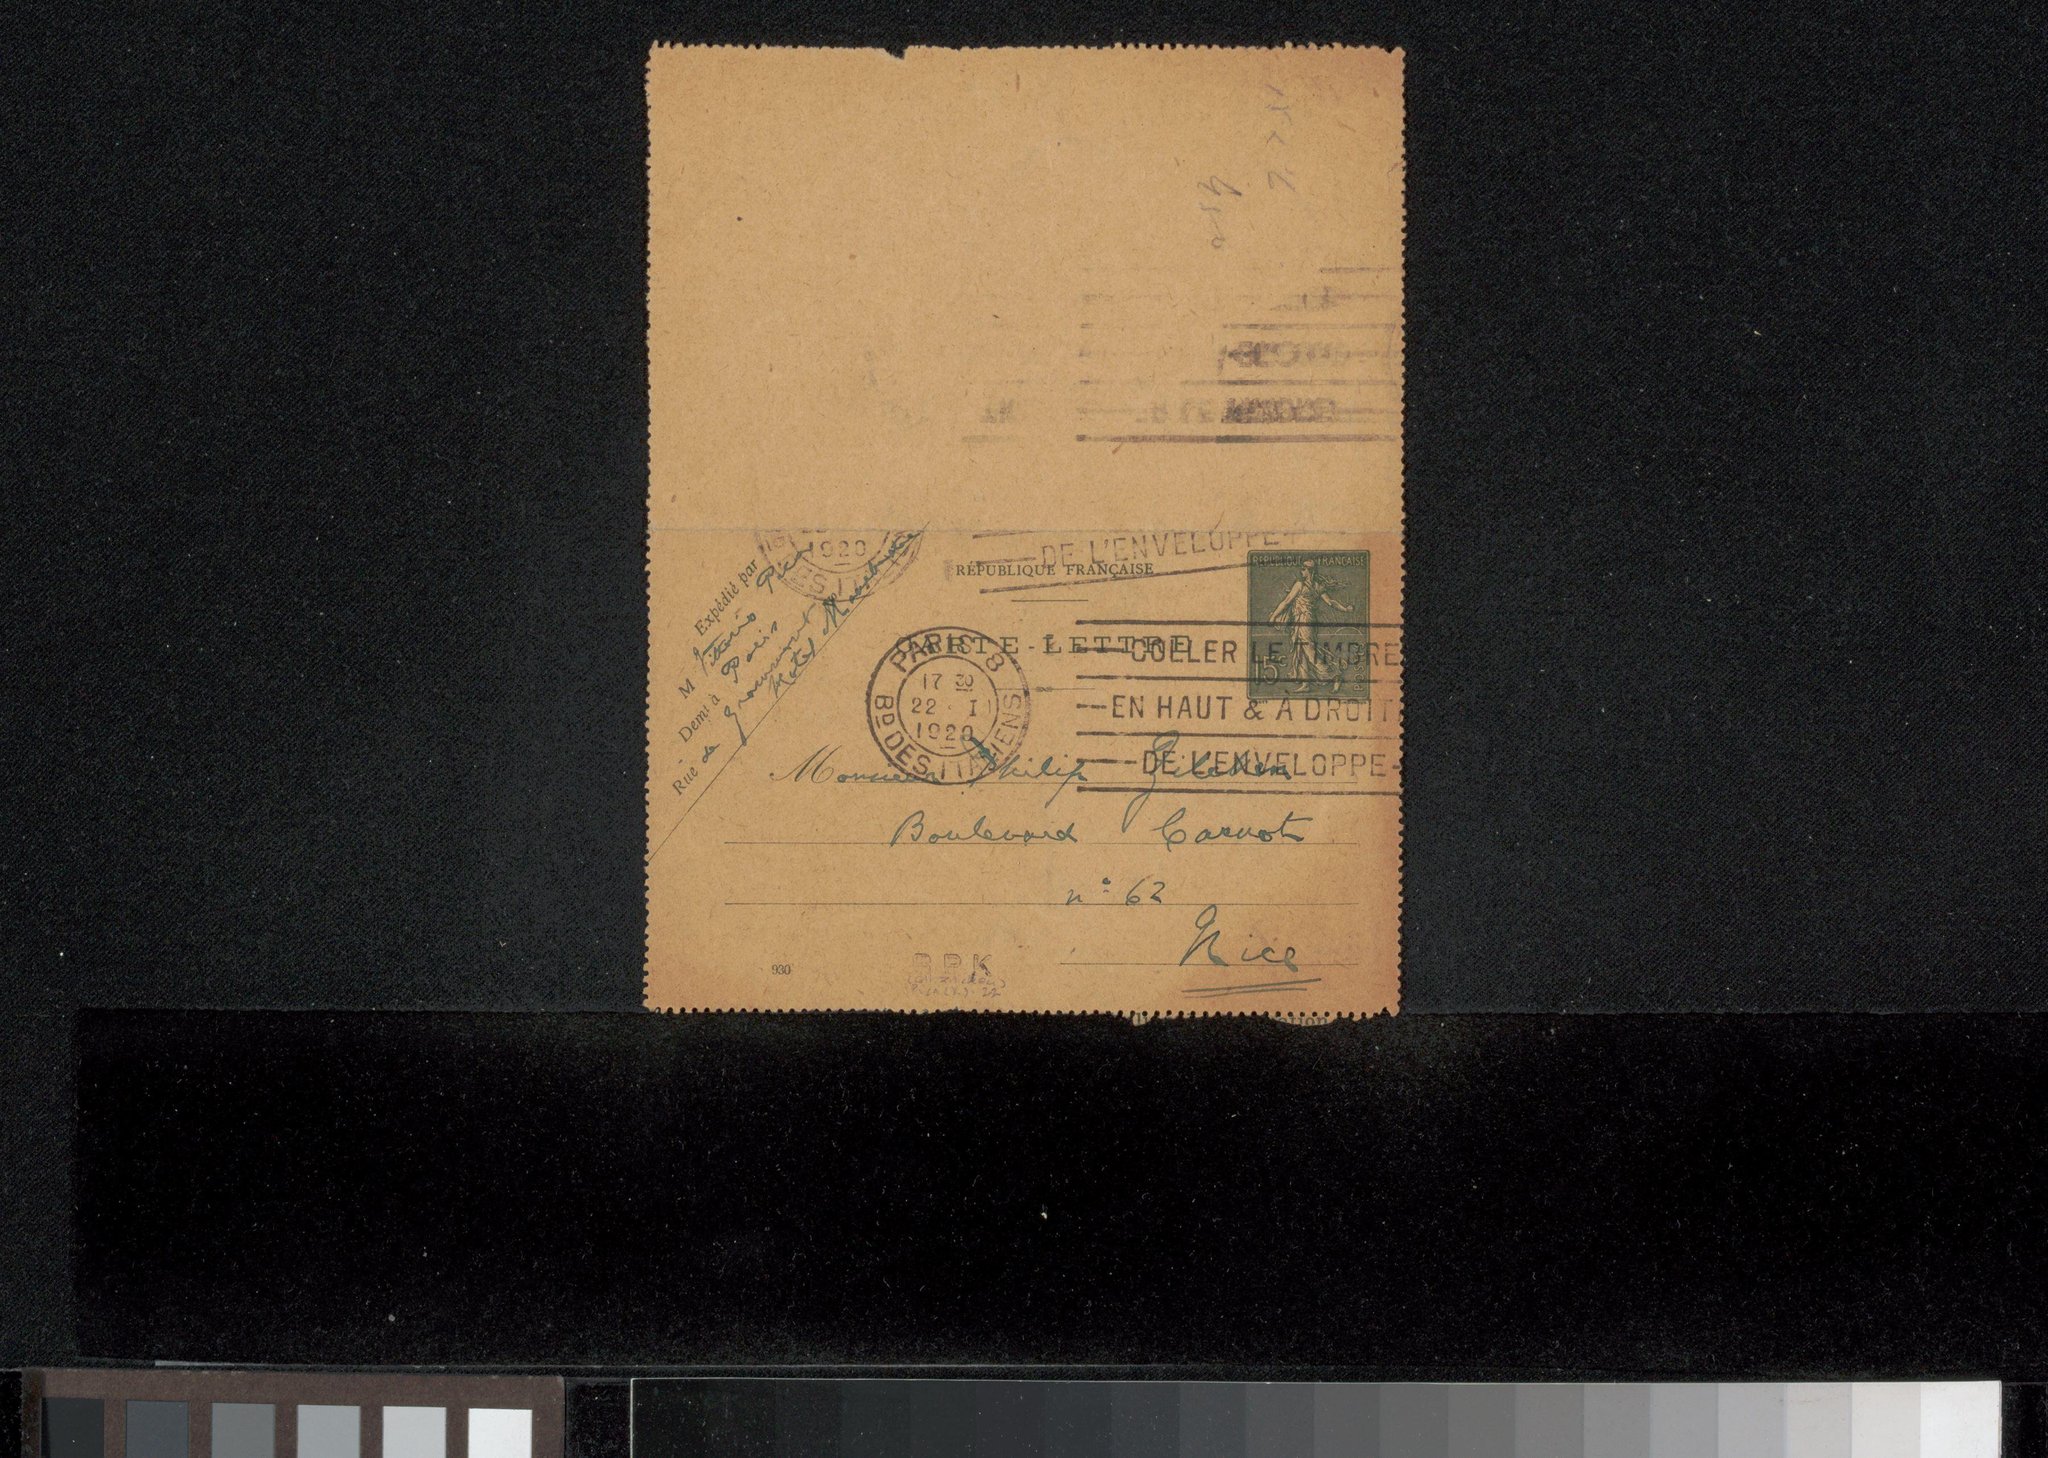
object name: postcard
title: Briefkaart aan Philip Zilcken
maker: vittorio pica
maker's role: criticus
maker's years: 1864-1930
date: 1920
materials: cardboard, ink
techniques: pen, writing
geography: paris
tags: print maker, vincent van gogh, venice, the hague, draughtsman, philip zilcken, painting (including book-illumination, miniature-painting), exhibition ~ art, money, italy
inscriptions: collector's mark: ‘RPK’